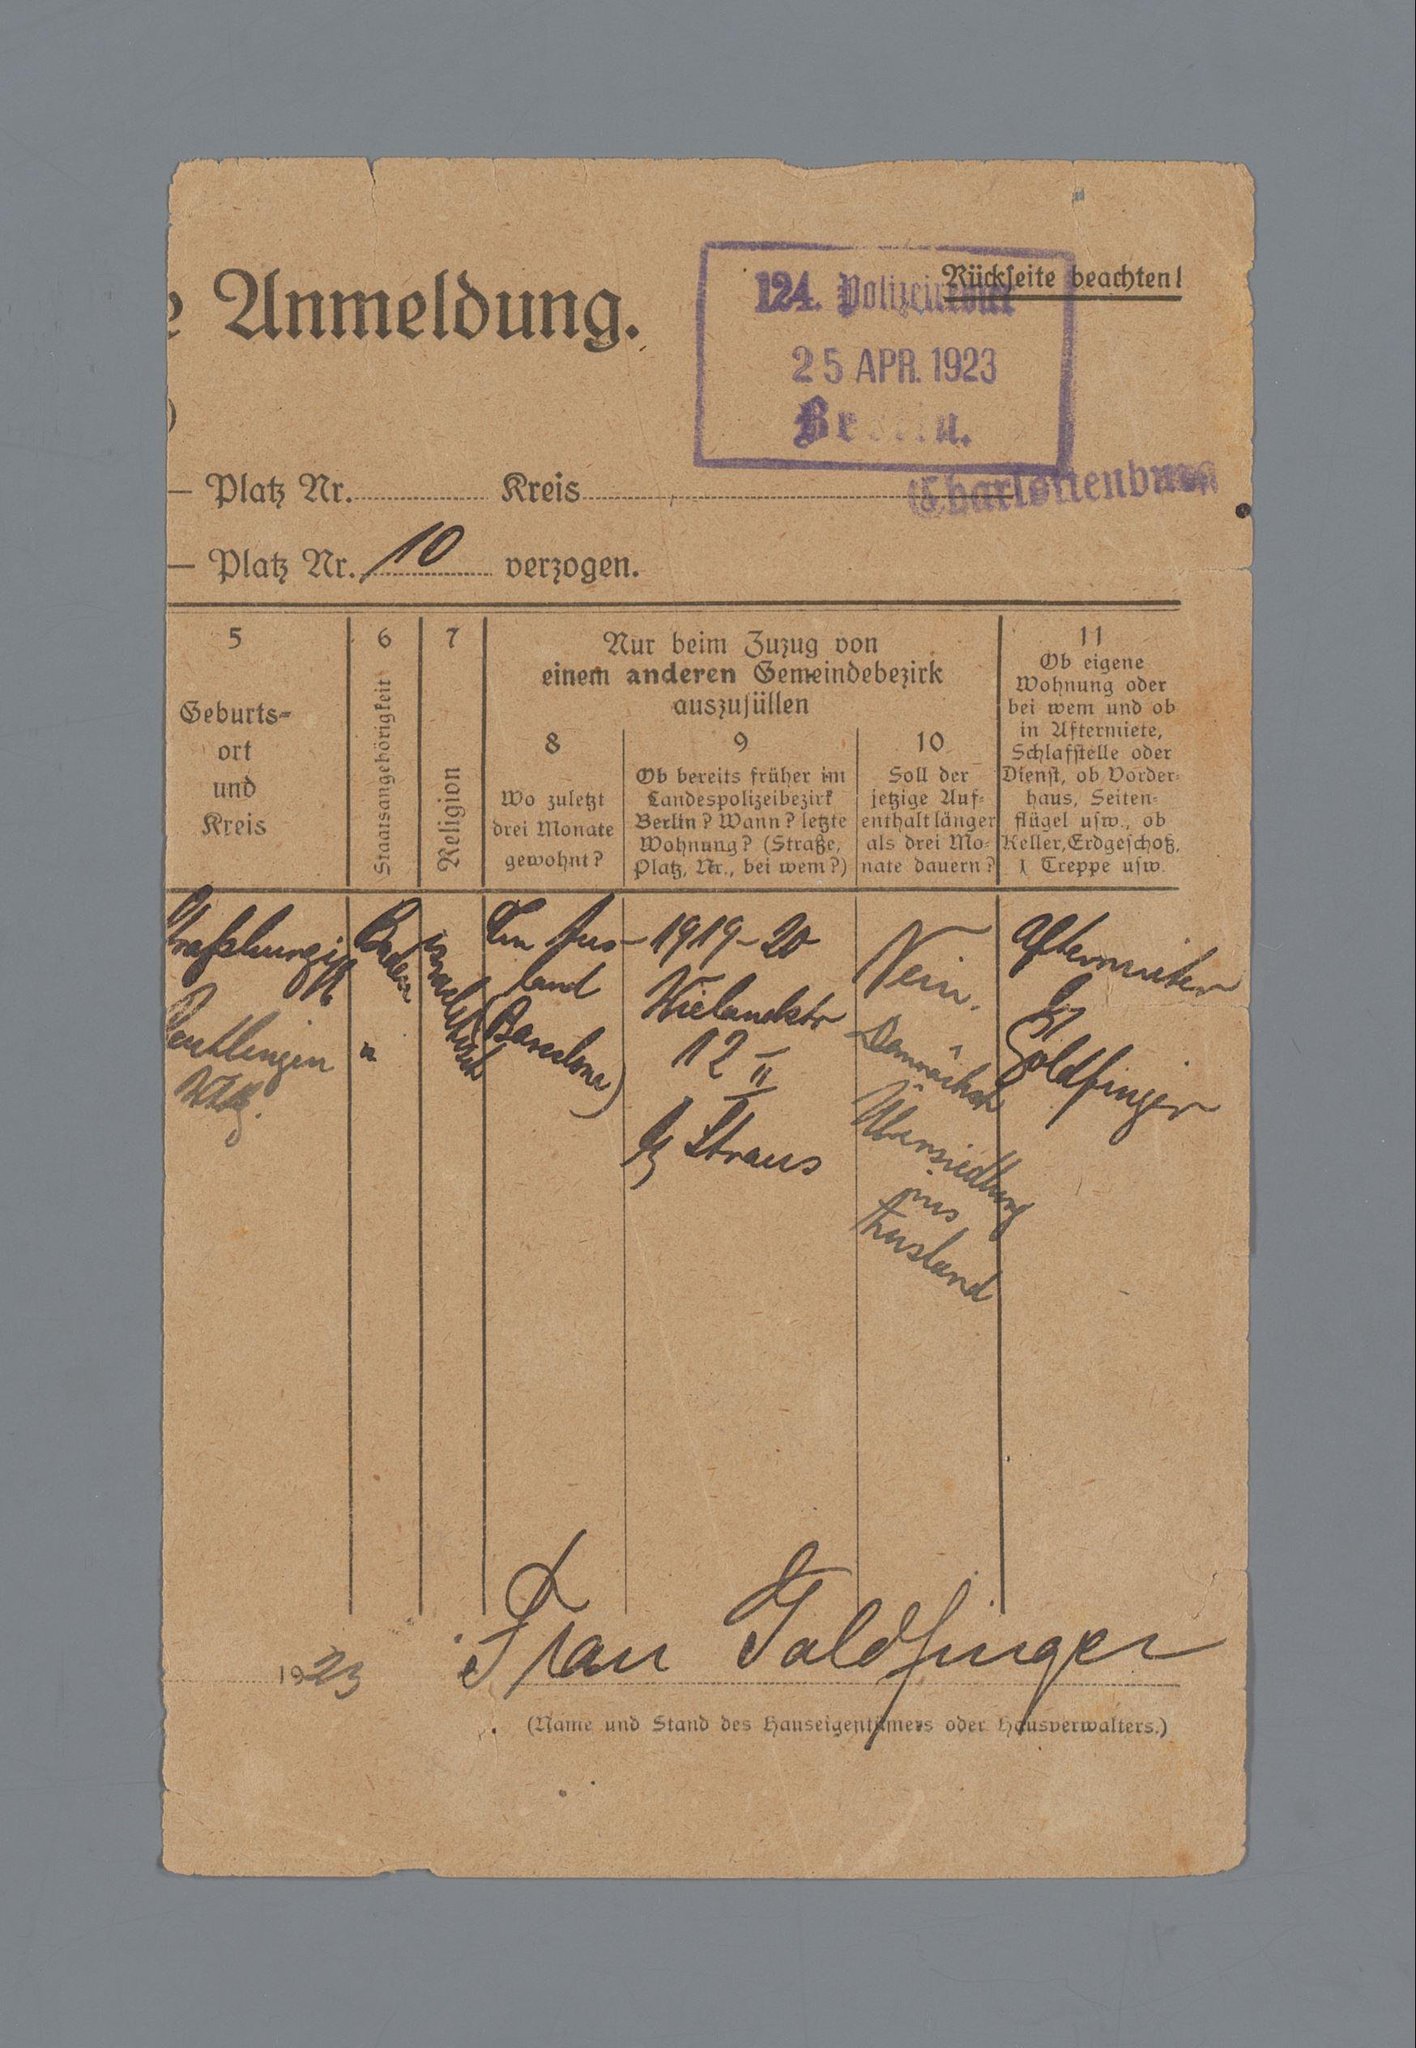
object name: document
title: Administratie uit de marine tijd van Eugen Wachenheimer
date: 1917-1933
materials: paper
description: Dit object is onderdeel van de nalatenschap van Isabel Elon-Wachenheimer (1928-2010). Tot haar overlijden behoorde het samen met de andere objecten uit de nalatenschap tot haar privédomein van Isabel Wachenheimer. In die particuliere context zijn deze objecten tezamen en individueel aandenkens - aan de jeugd, ouders en familie van Isabel Wachenheimer vóór en tijdens de Shoah en aan haar leven na de Tweede Wereldoorlog. Isabel Wachenheimer, die van juni 1943 tot mei 1945 gevangen zat in Kamp Westerbork, Theresienstadt, Auschwitz, Lenzing a/d Oberdonau (een buitenkamp van Mauthausen), overleefde de Shoah. Haar ouders – Eugène Wachenheimer en Else Wachenheimer-Moos - werden op 14 oktober 1944 in Auschwitz-Birkenau vermoord.